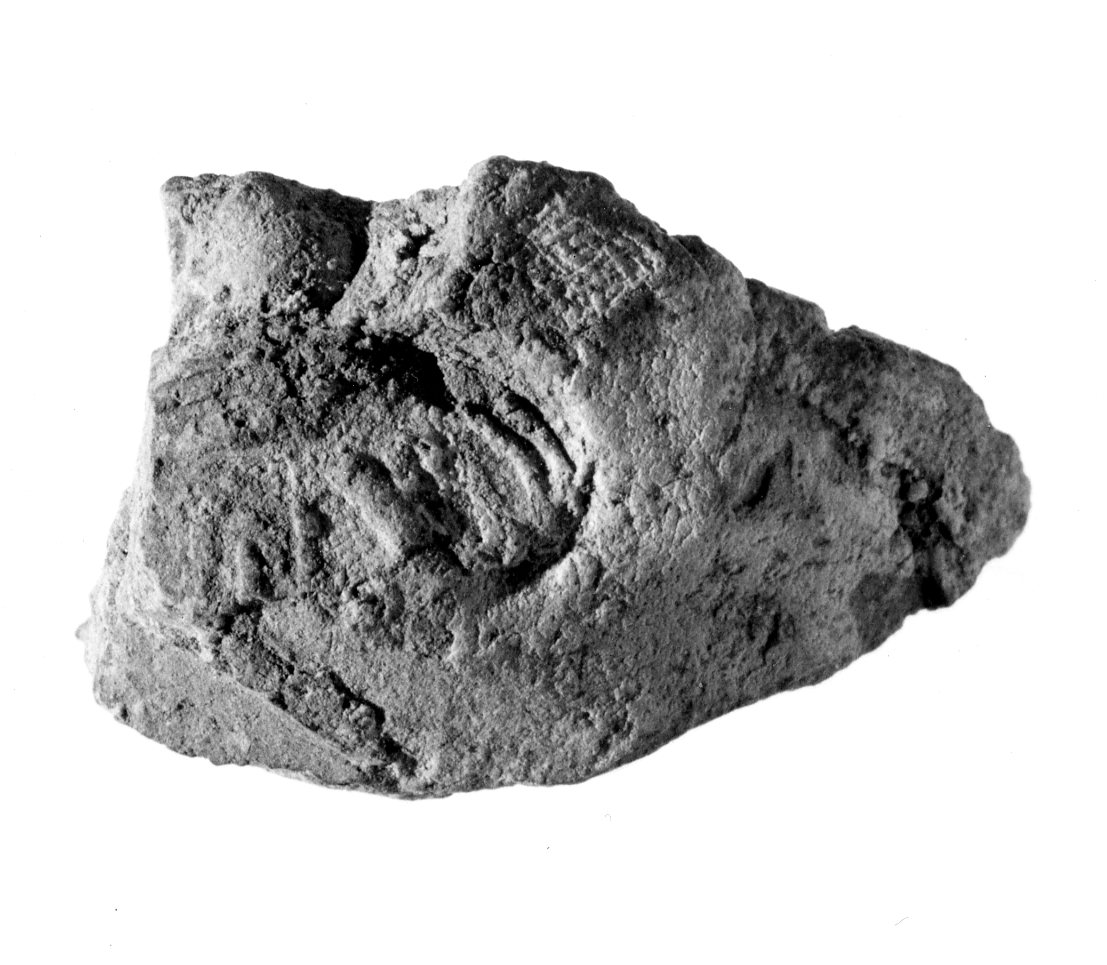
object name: sealing, amenhotep iii, nebmaatre. winged cobra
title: Document Sealing with the Throne Name of Amenhotep III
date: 1390-1352 BCE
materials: mud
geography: egypt